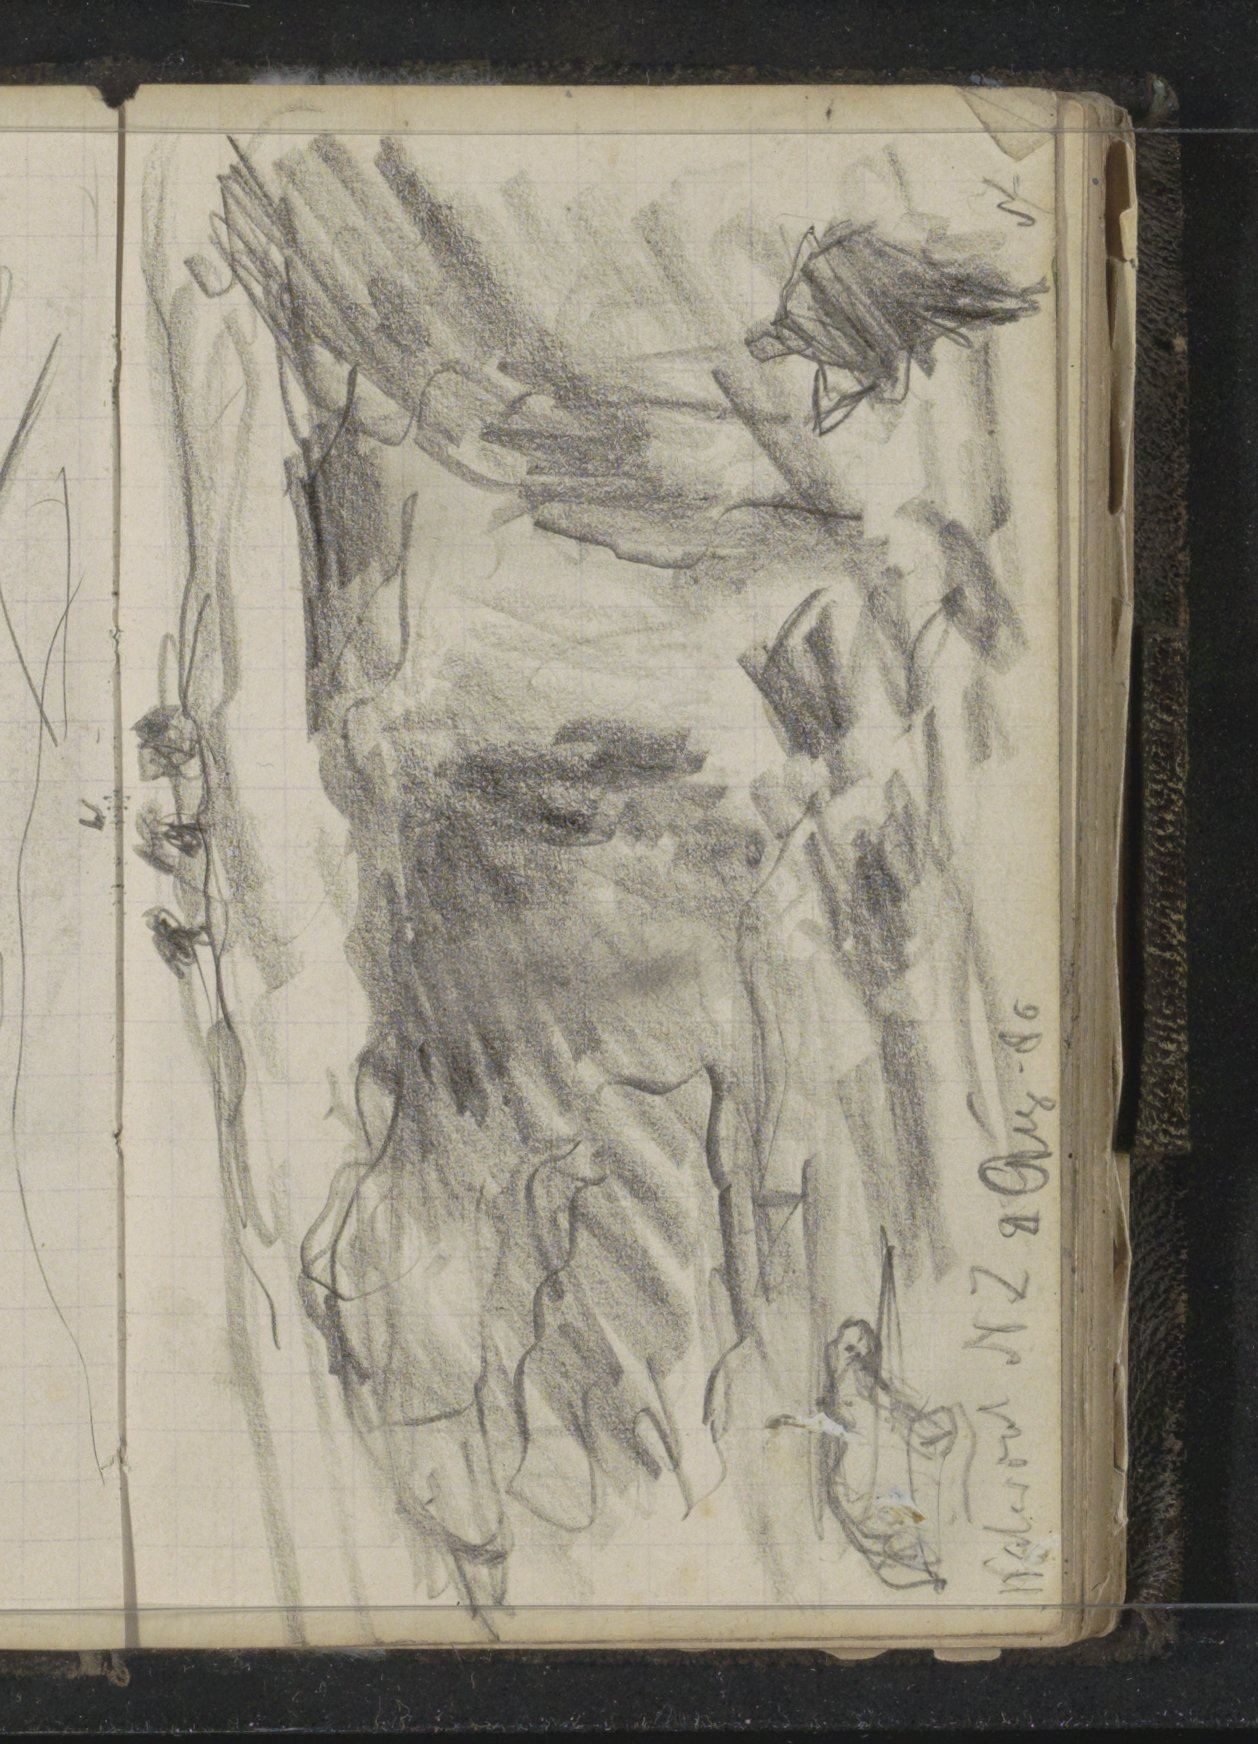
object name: sketchbook leaf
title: Figuren bij een waterval op Nova Zembla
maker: louis apol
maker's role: draughtsman, painter, print maker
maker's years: 1850-1936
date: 1880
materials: pencil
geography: novaya zemlya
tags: waterfall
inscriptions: annotation: ‘Waterval N Z 21 Aug. 80’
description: Links mogelijk een ijsbeer. Blad 55 recto uit een schetsboek met 110 bladen betekend tijdens de expeditie naar Nova Zembla in 1880.